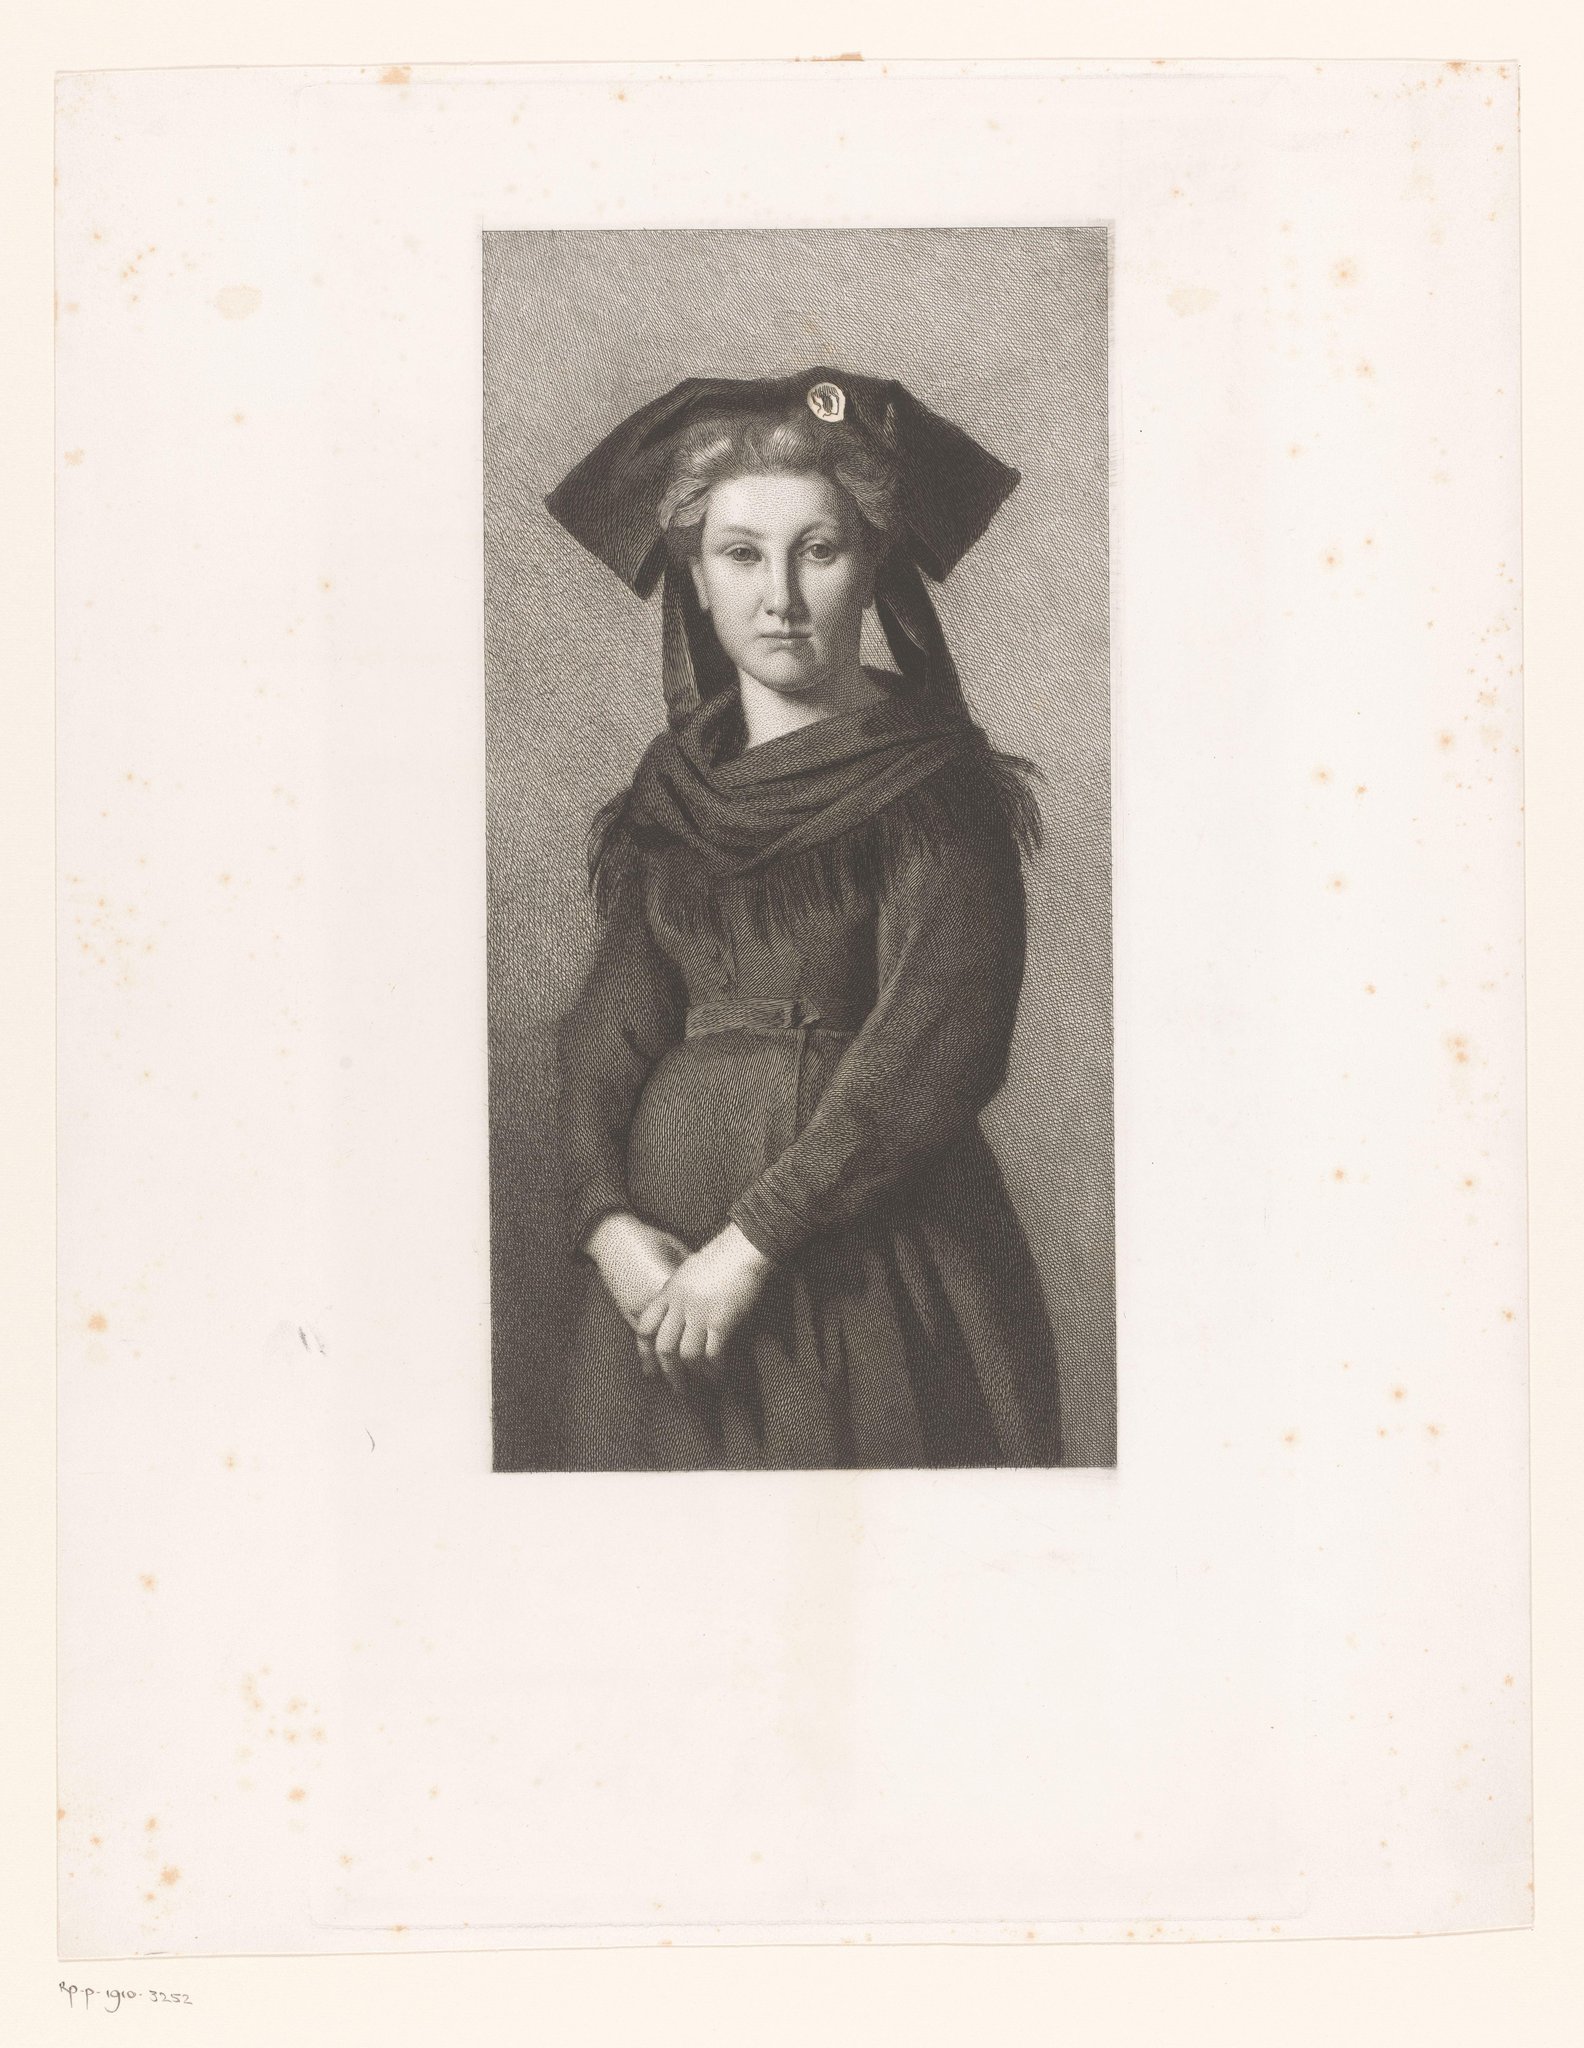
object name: print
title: Portret van een onbekende vrouw in Elzasser klederdracht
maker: léopold flameng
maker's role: print maker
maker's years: 1831-1911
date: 1841-1910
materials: paper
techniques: etching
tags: anonymous historical person portrayed alone - bb - woman, folk costume, regional costume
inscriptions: annotation: ‘L'Alsace Lorraine / ep. d'artiste’